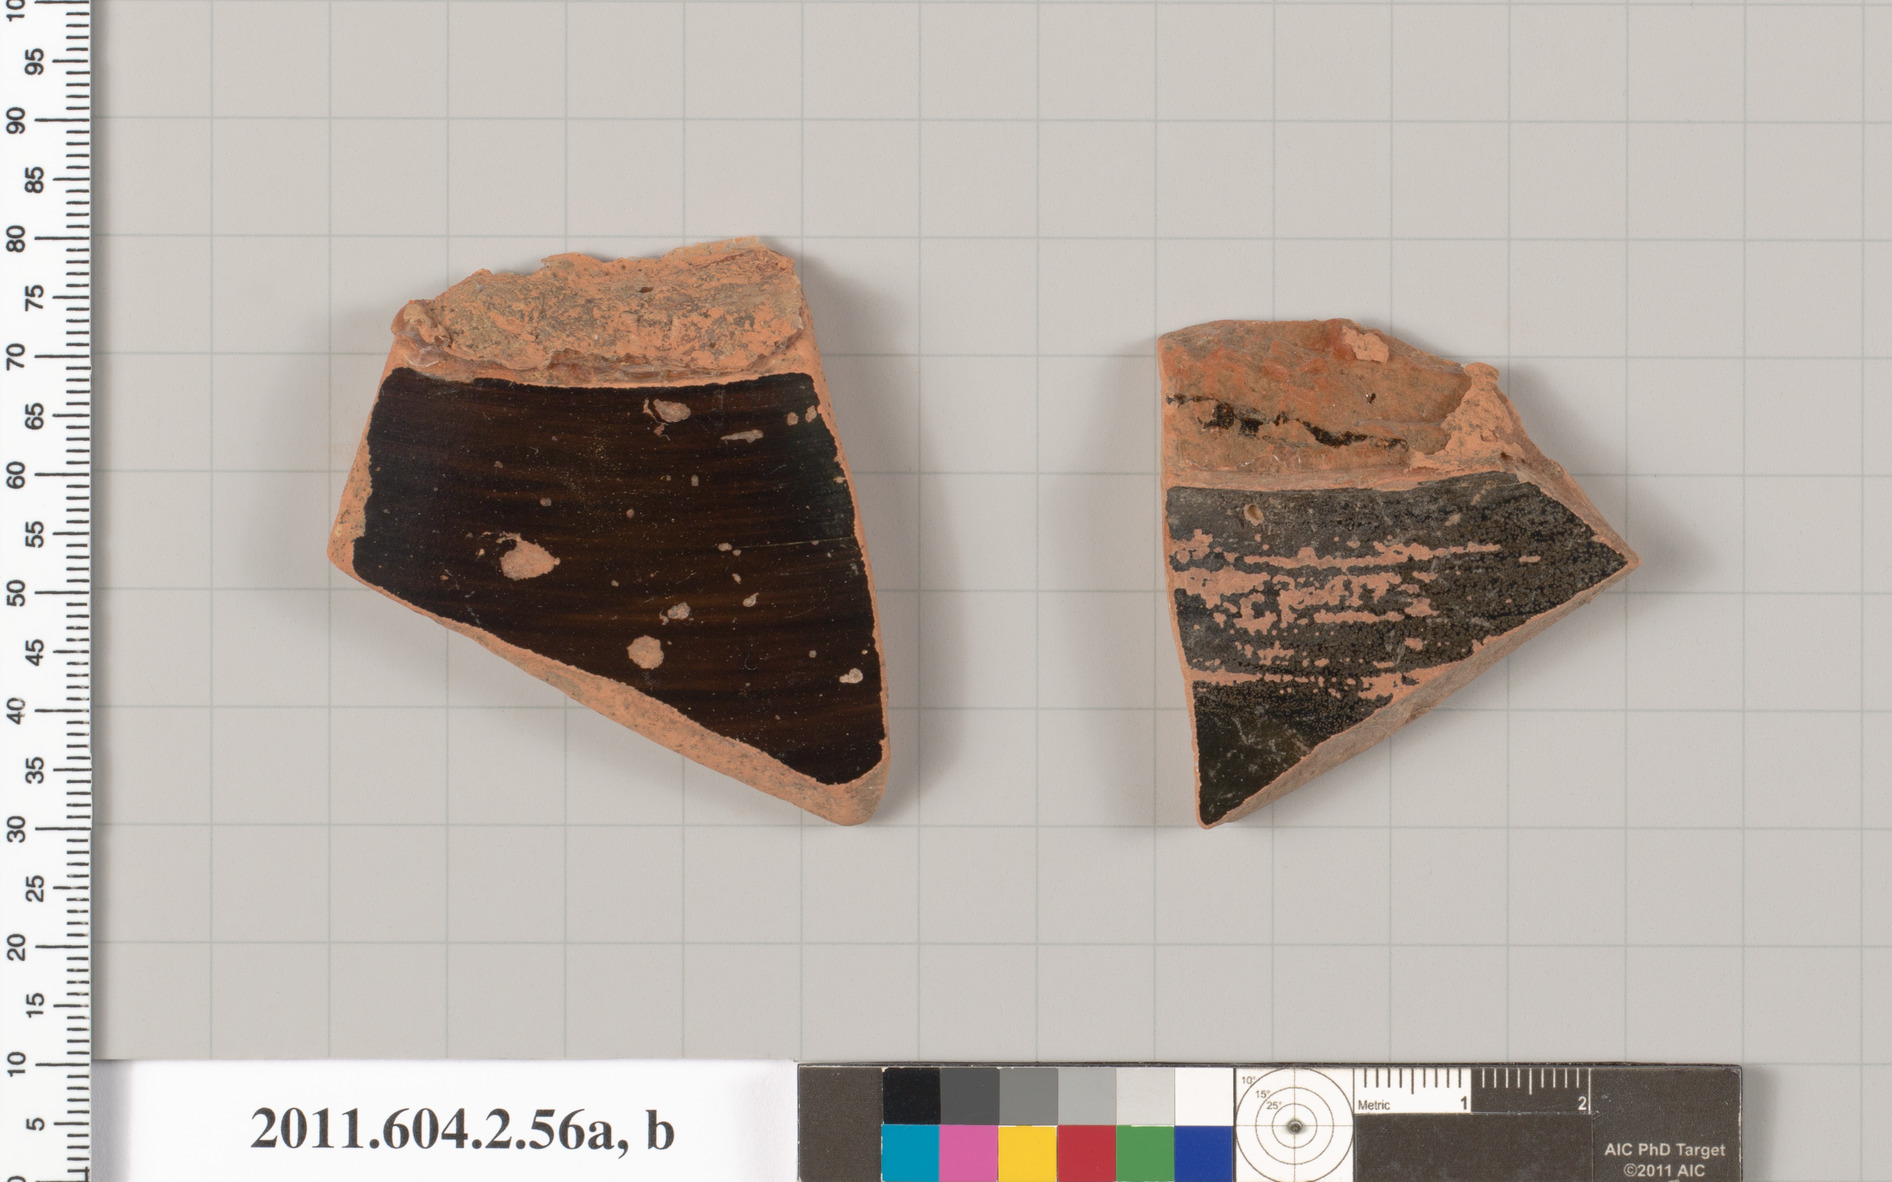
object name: pot fragment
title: Terracotta fragments of a pot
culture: greek, attic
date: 534-468 BCE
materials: terracotta